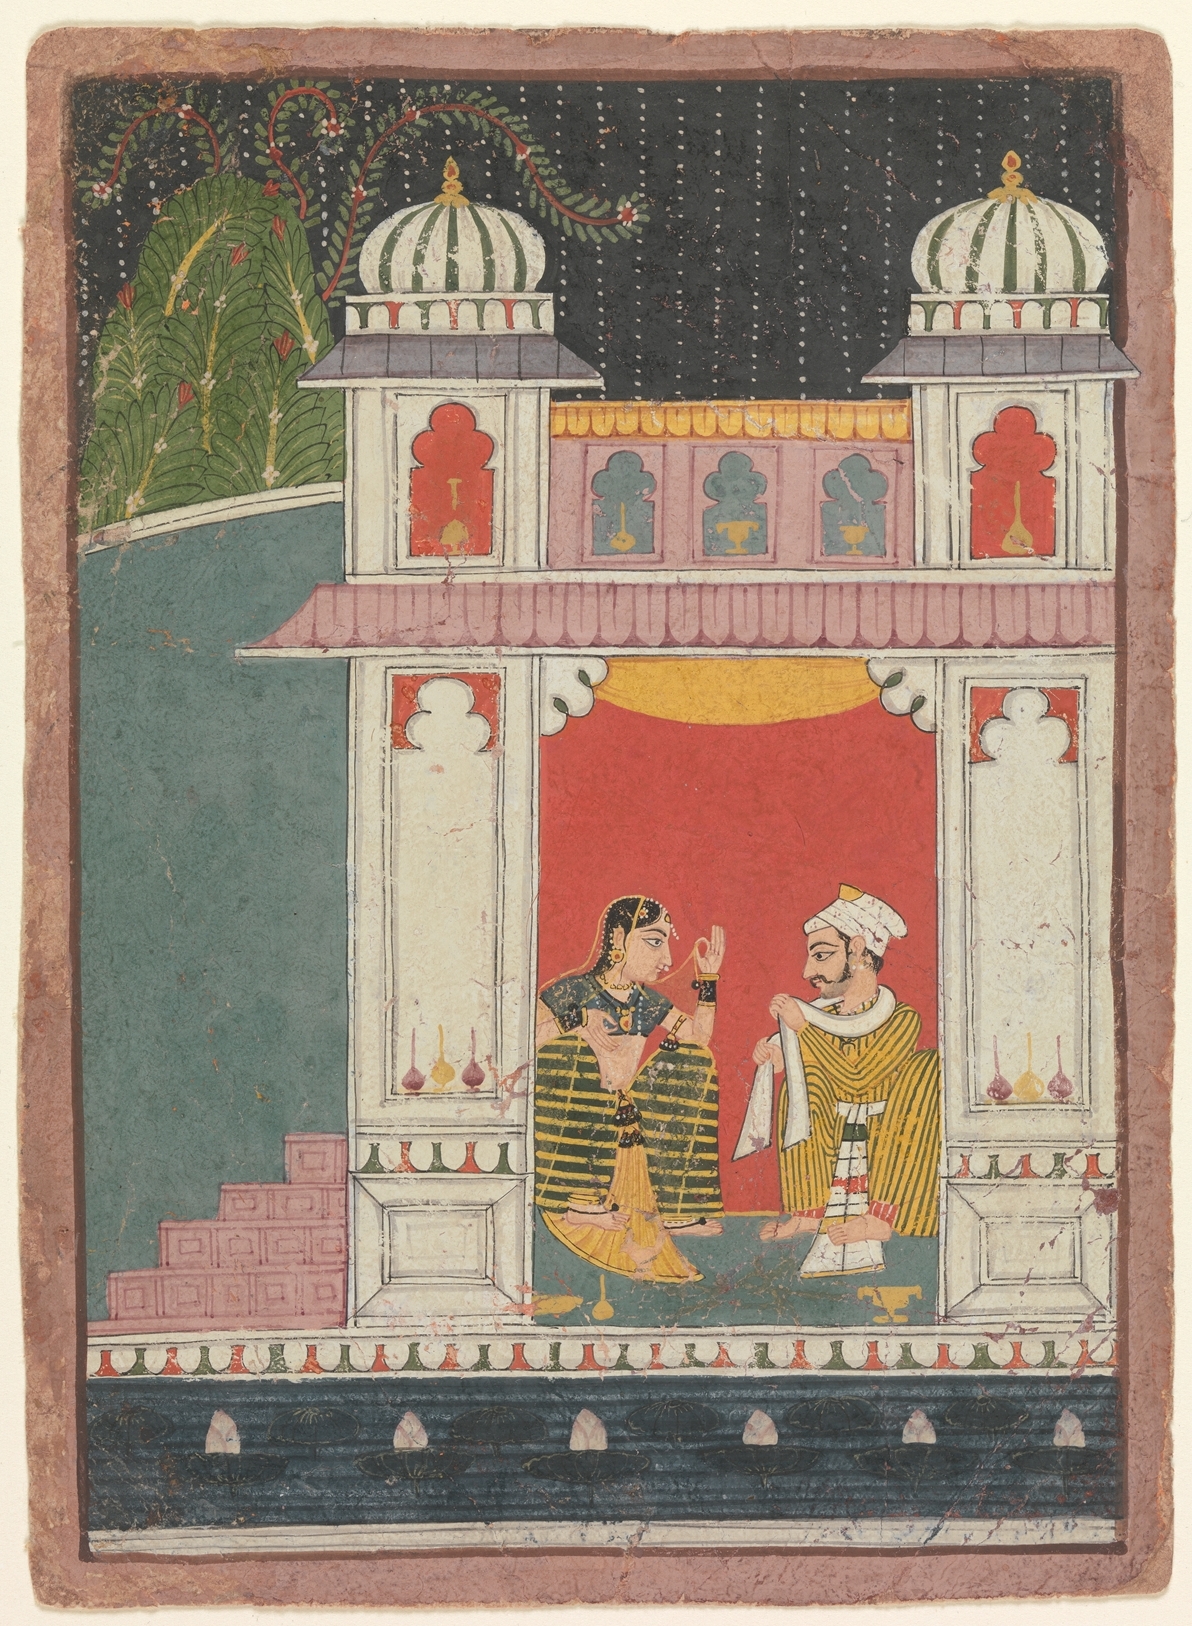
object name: folio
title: A Heroine and Her Lover in a Pavilion: Page from a Dispersed Nayikabheda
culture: indian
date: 1660-1680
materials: ink, paper, watercolor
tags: couples,men,women,pavilions